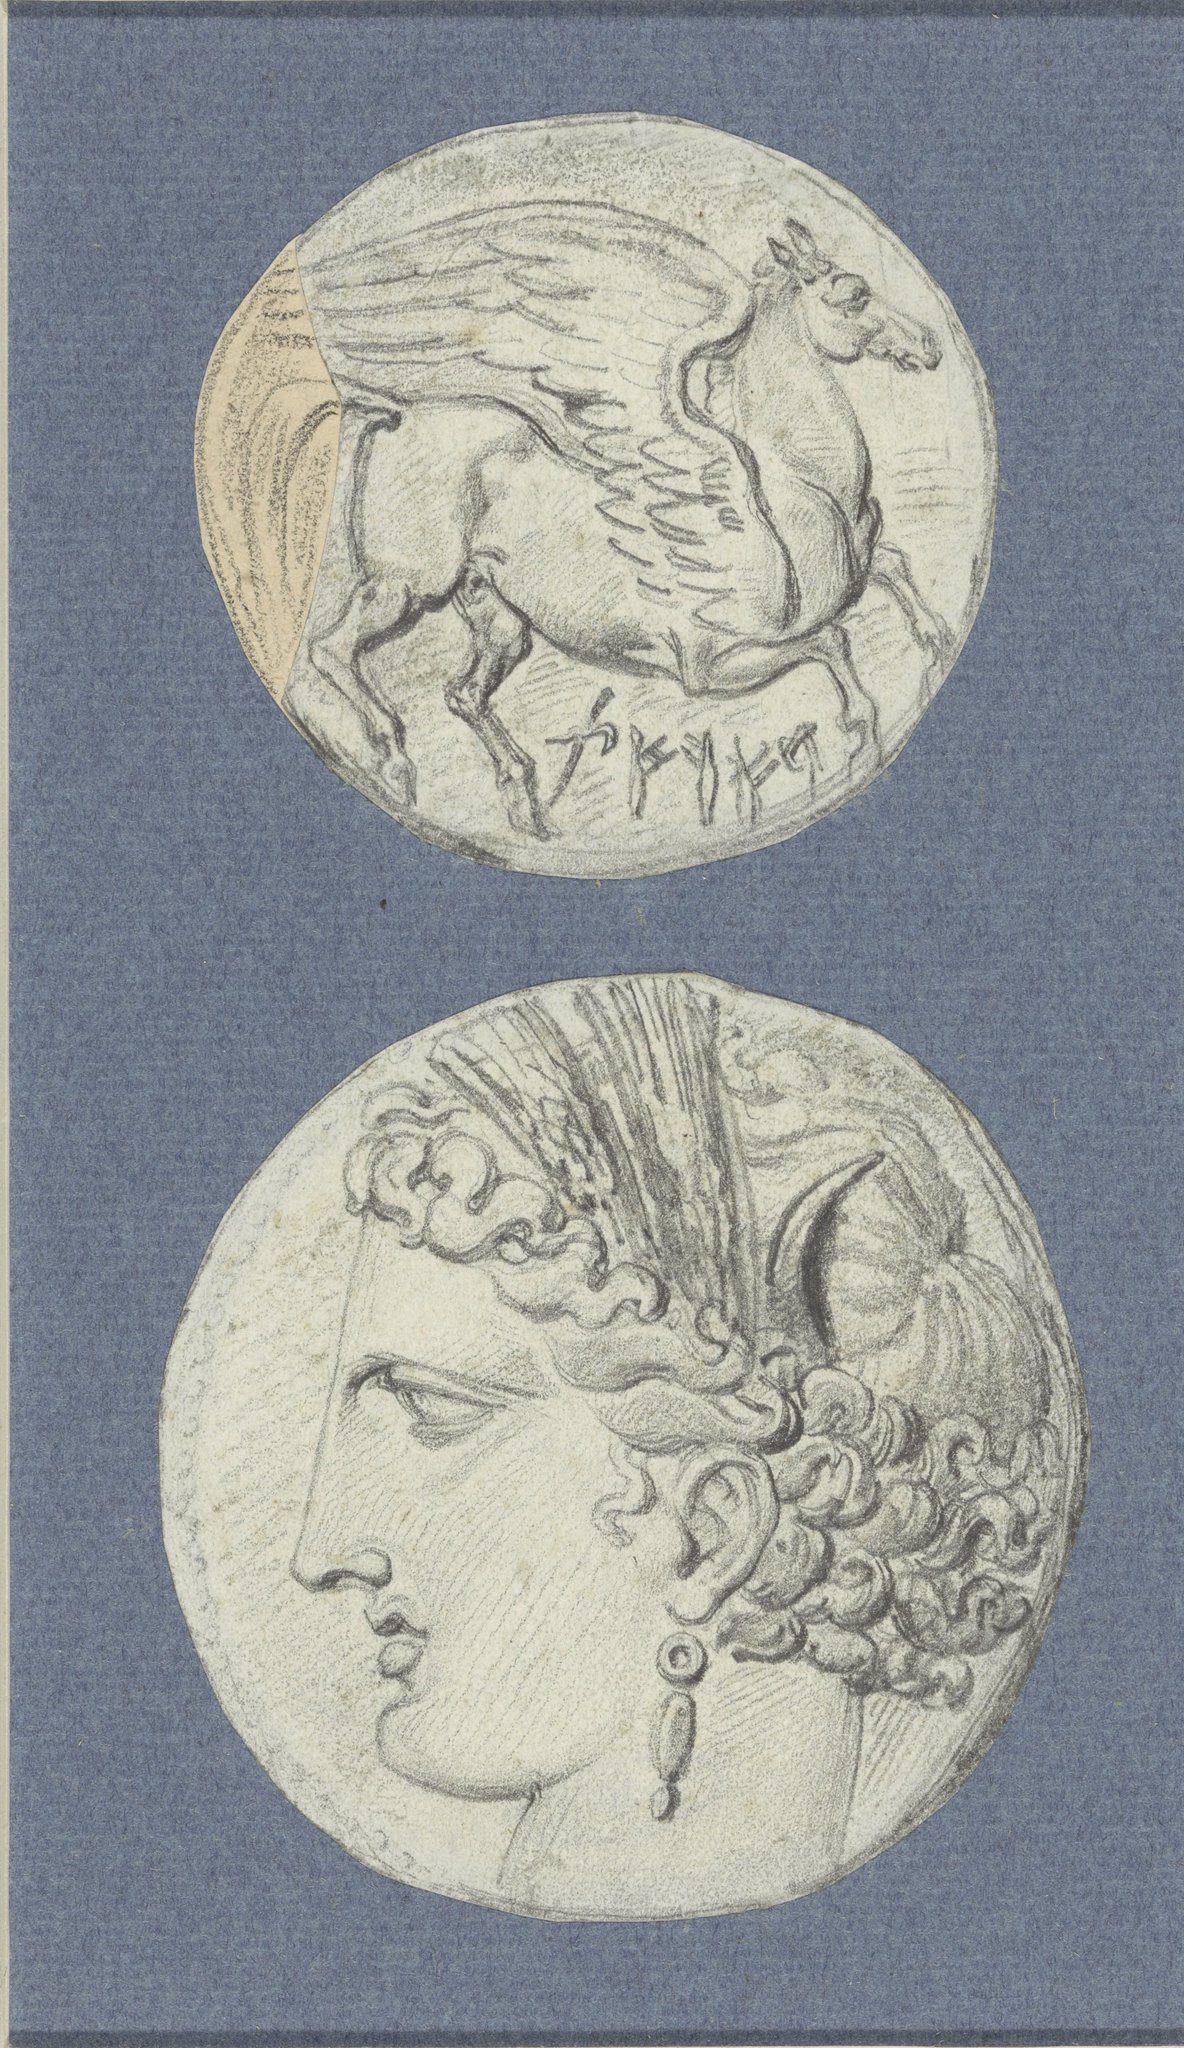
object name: drawing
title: Steigerende Pegasus met inscriptie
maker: achille devéria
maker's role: draughtsman, painter, print maker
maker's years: 1800-1857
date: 1825-1857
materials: paper, pencil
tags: pegasus, the winged horse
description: Pendant van "Voorzijde van een grote (Carthageense?) munt met het hoofd van Persephone" (inv. nr. RP-T-1959-141).